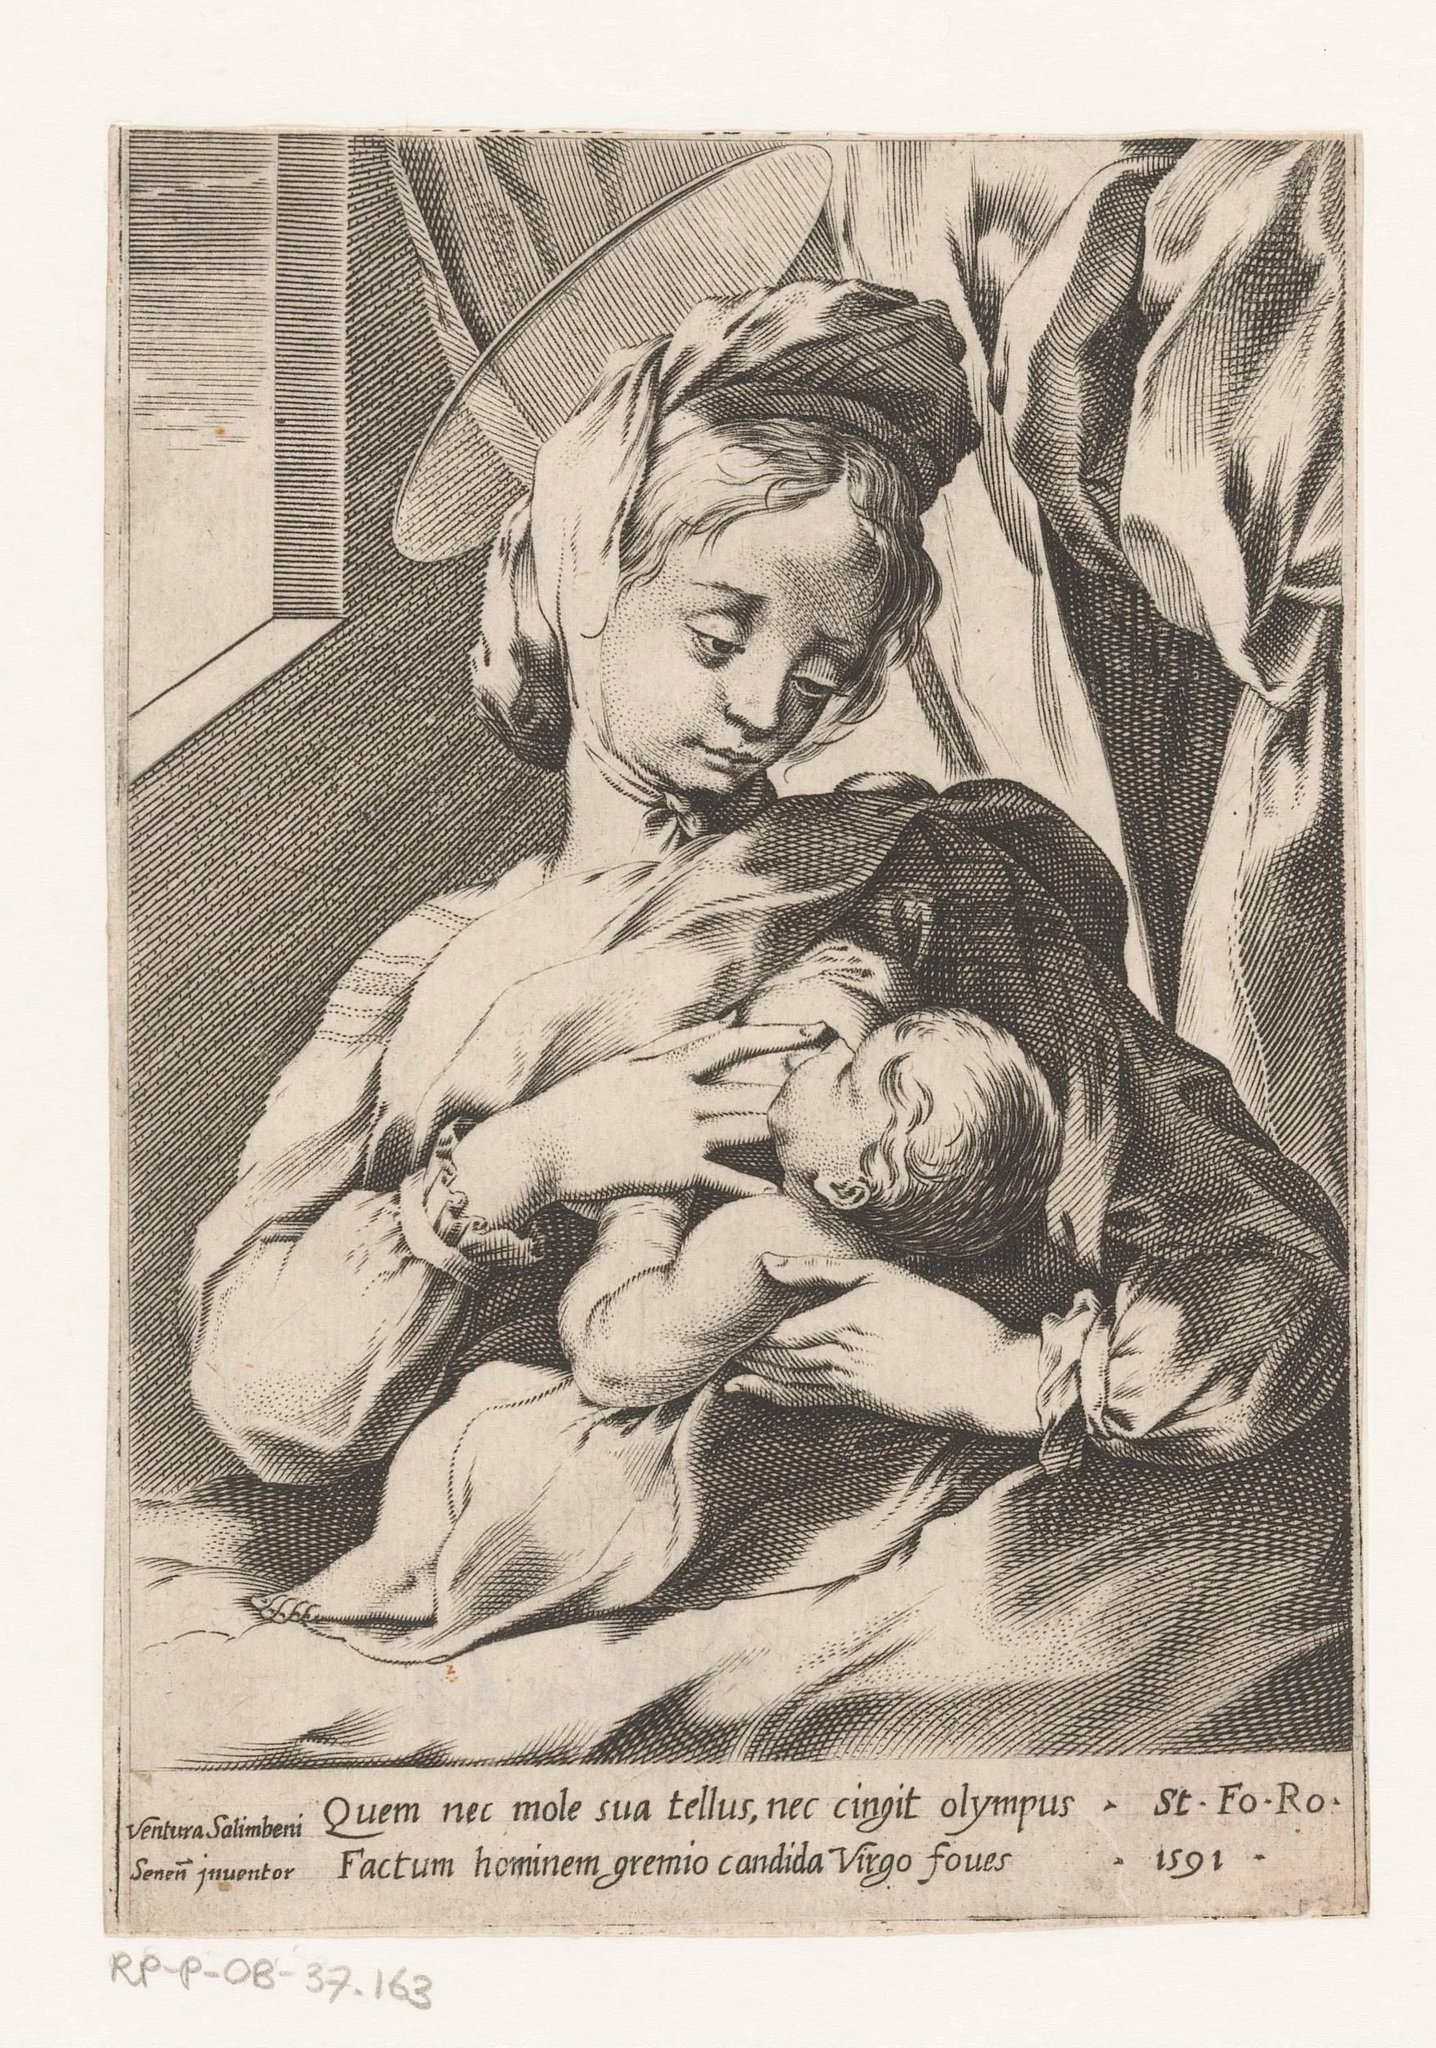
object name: print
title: Maria het Kind zogend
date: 1591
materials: paper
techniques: engraving, etching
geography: rome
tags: christ-child suckling, or beginning to suckle, e.g. mary uncovering her breast ~ madonna-representations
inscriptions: : Lugt 789a, collector's mark: Lugt 240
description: Maria geeft het Christuskind de borst. Op de achtergrond een draperie. Links een venster. Onderschrift in het Latijn.